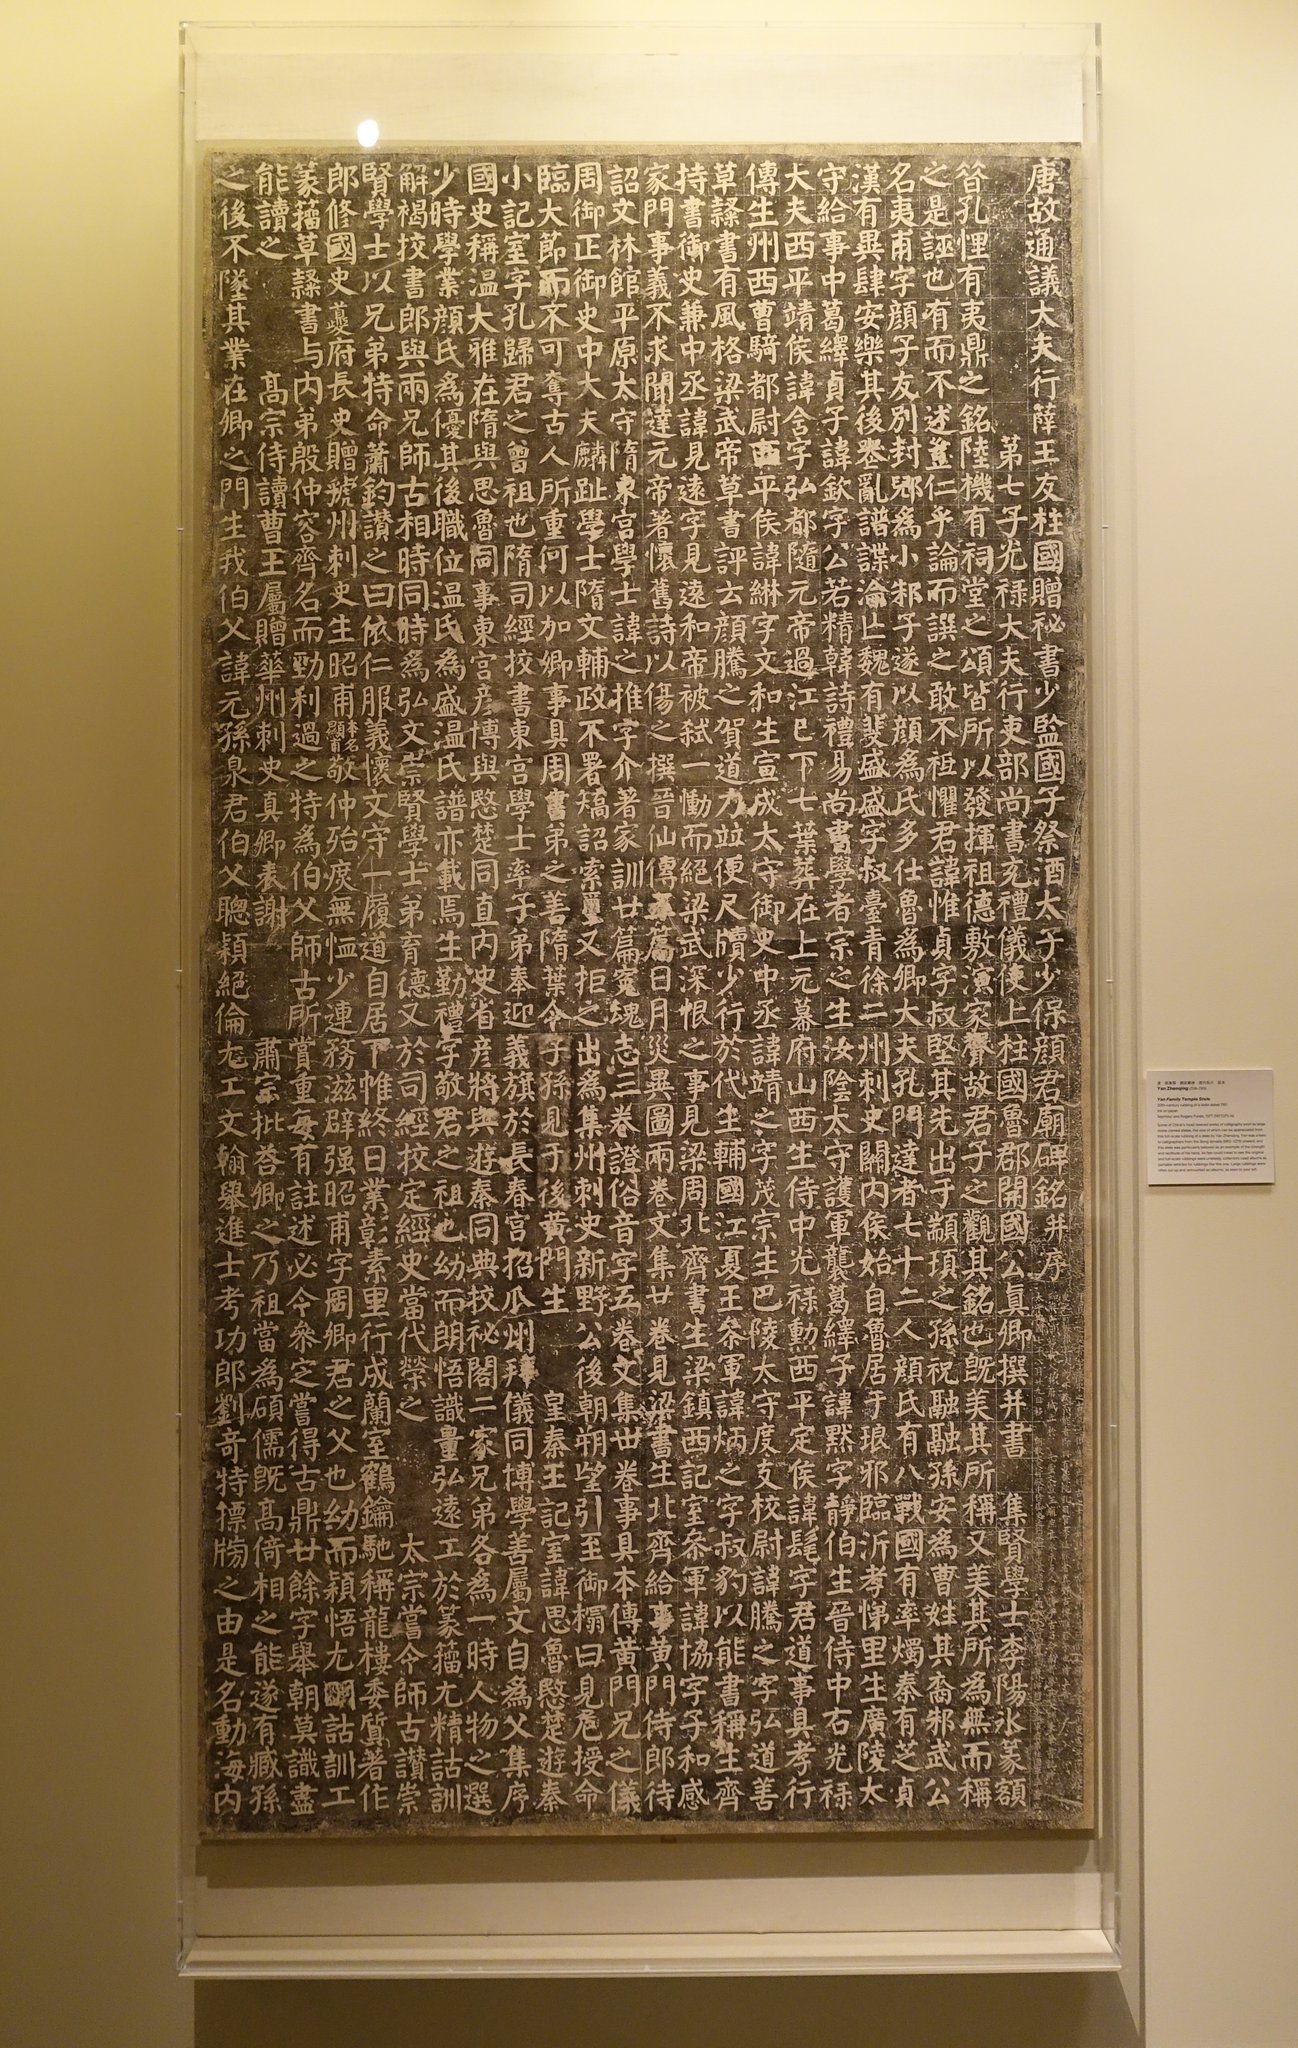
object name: rubbing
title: Yan Family Temple Stele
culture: chinese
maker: yan zhenqing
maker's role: artist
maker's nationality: chinese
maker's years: 709-785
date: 1901-2000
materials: ink, paper